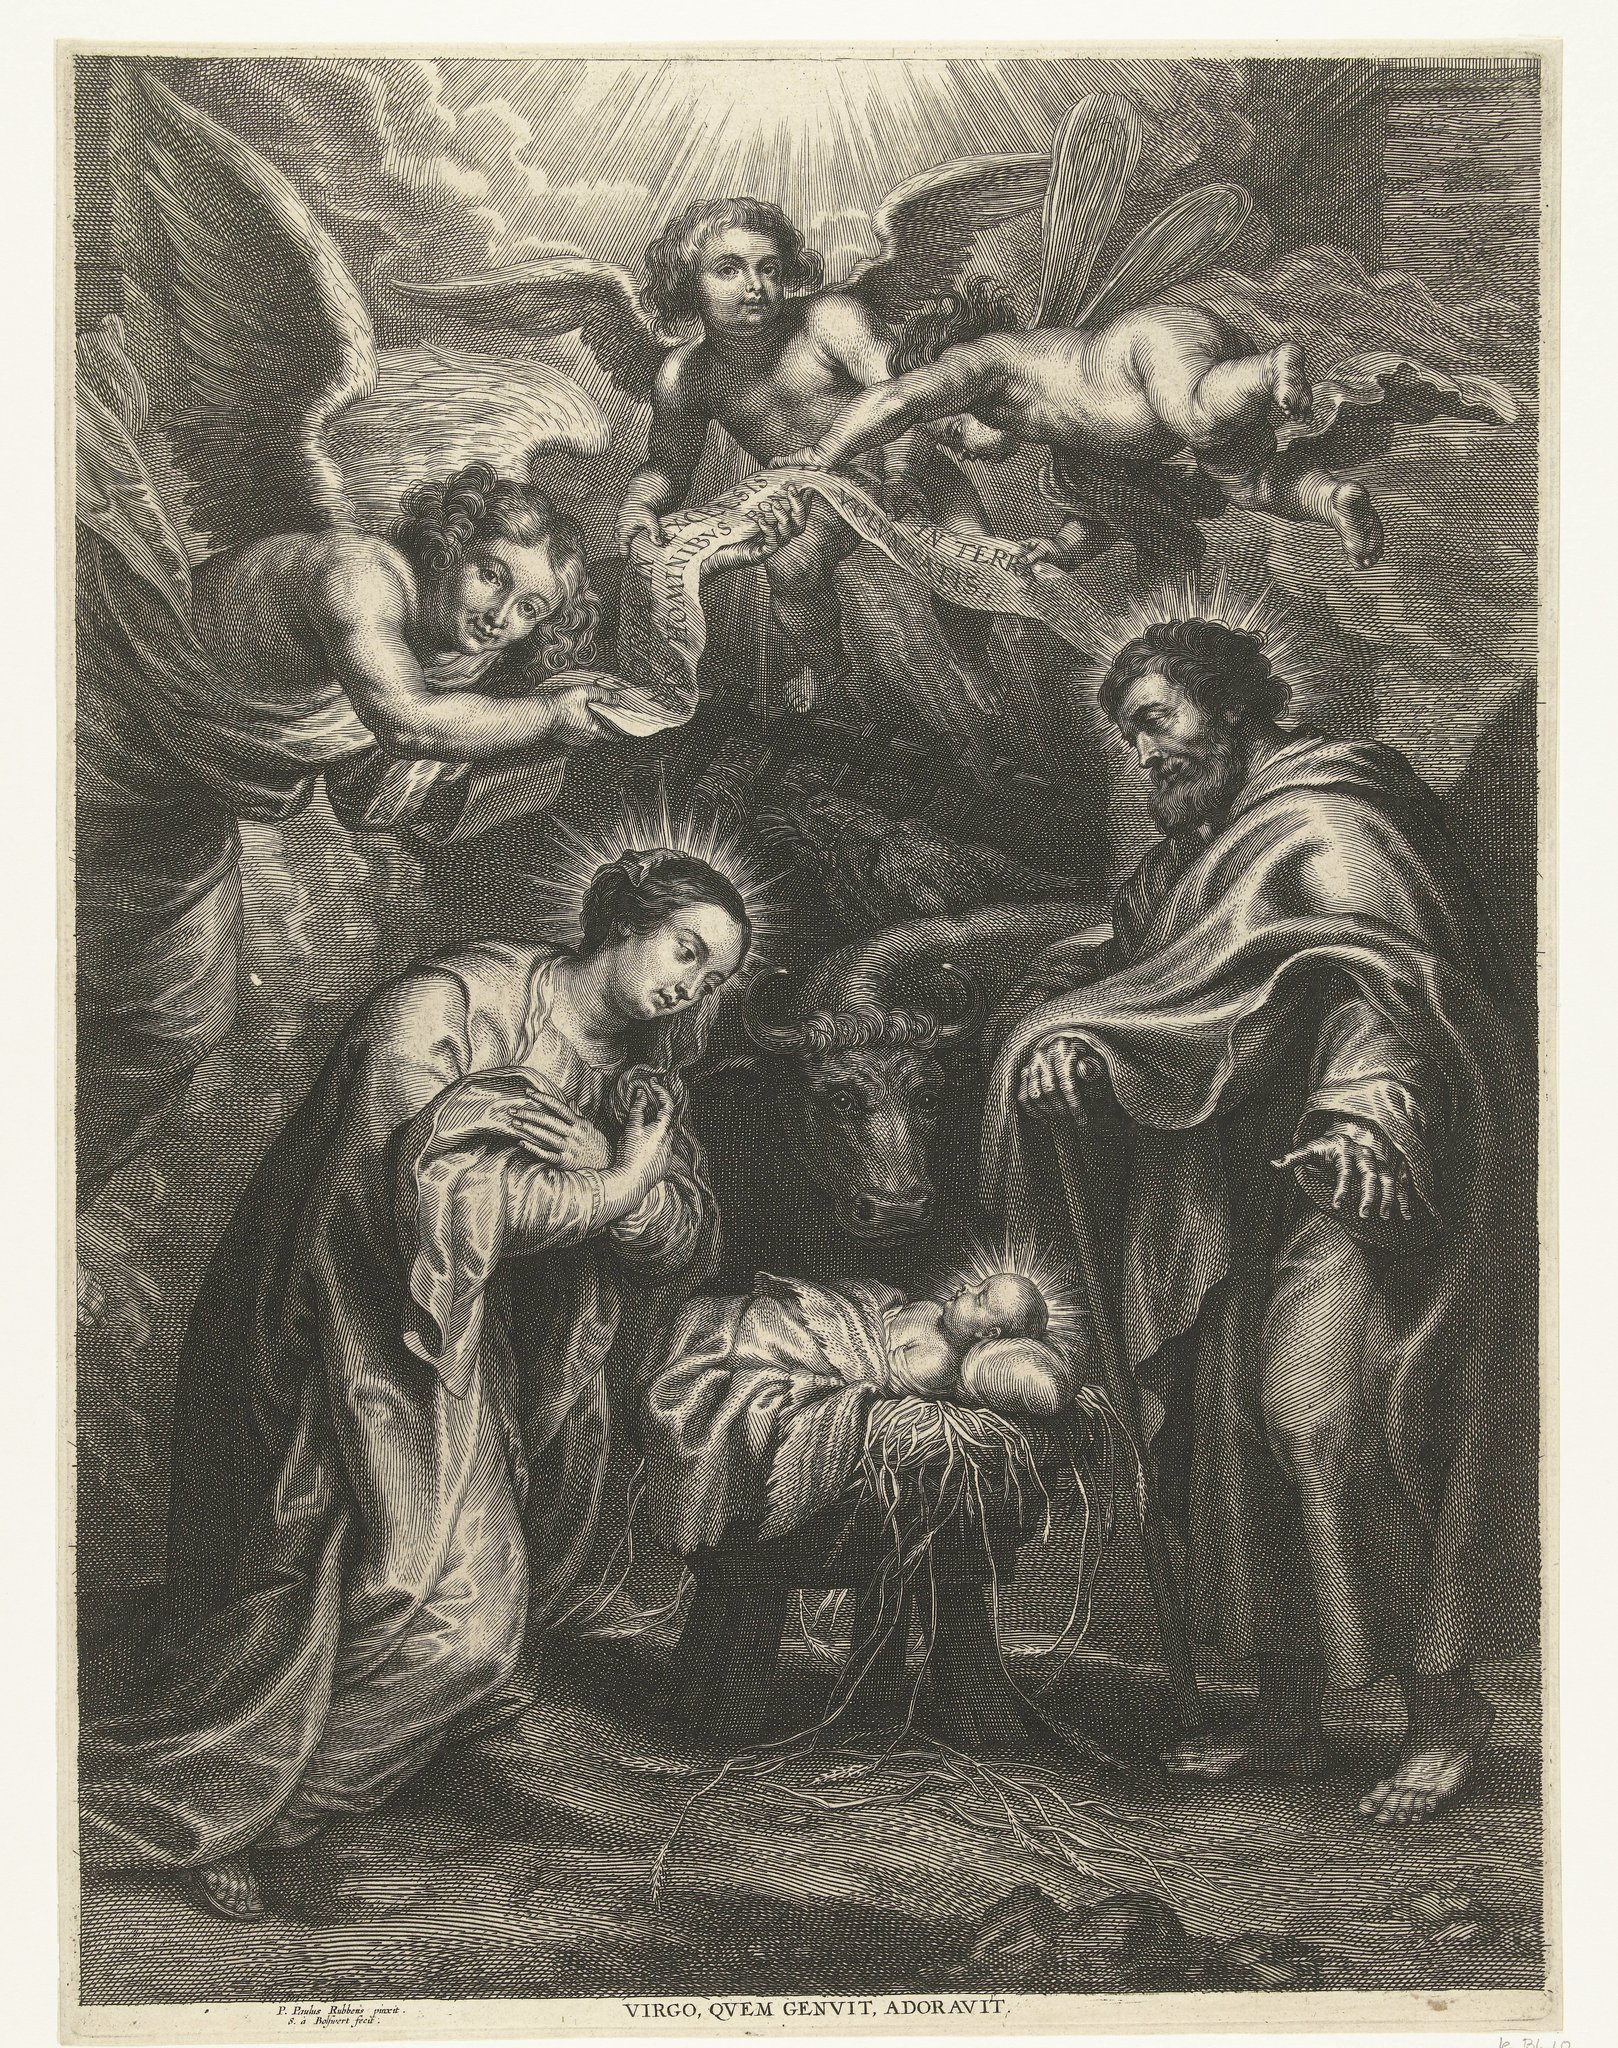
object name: print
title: Virgo qvem genvit adoravit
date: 1596-1659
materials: paper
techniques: engraving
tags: adoration of the christ-child by mary and joseph (+ angel(s))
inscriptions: collector's mark: Lugt 240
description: Prent naar schilderij van Peter Paul Rubens.